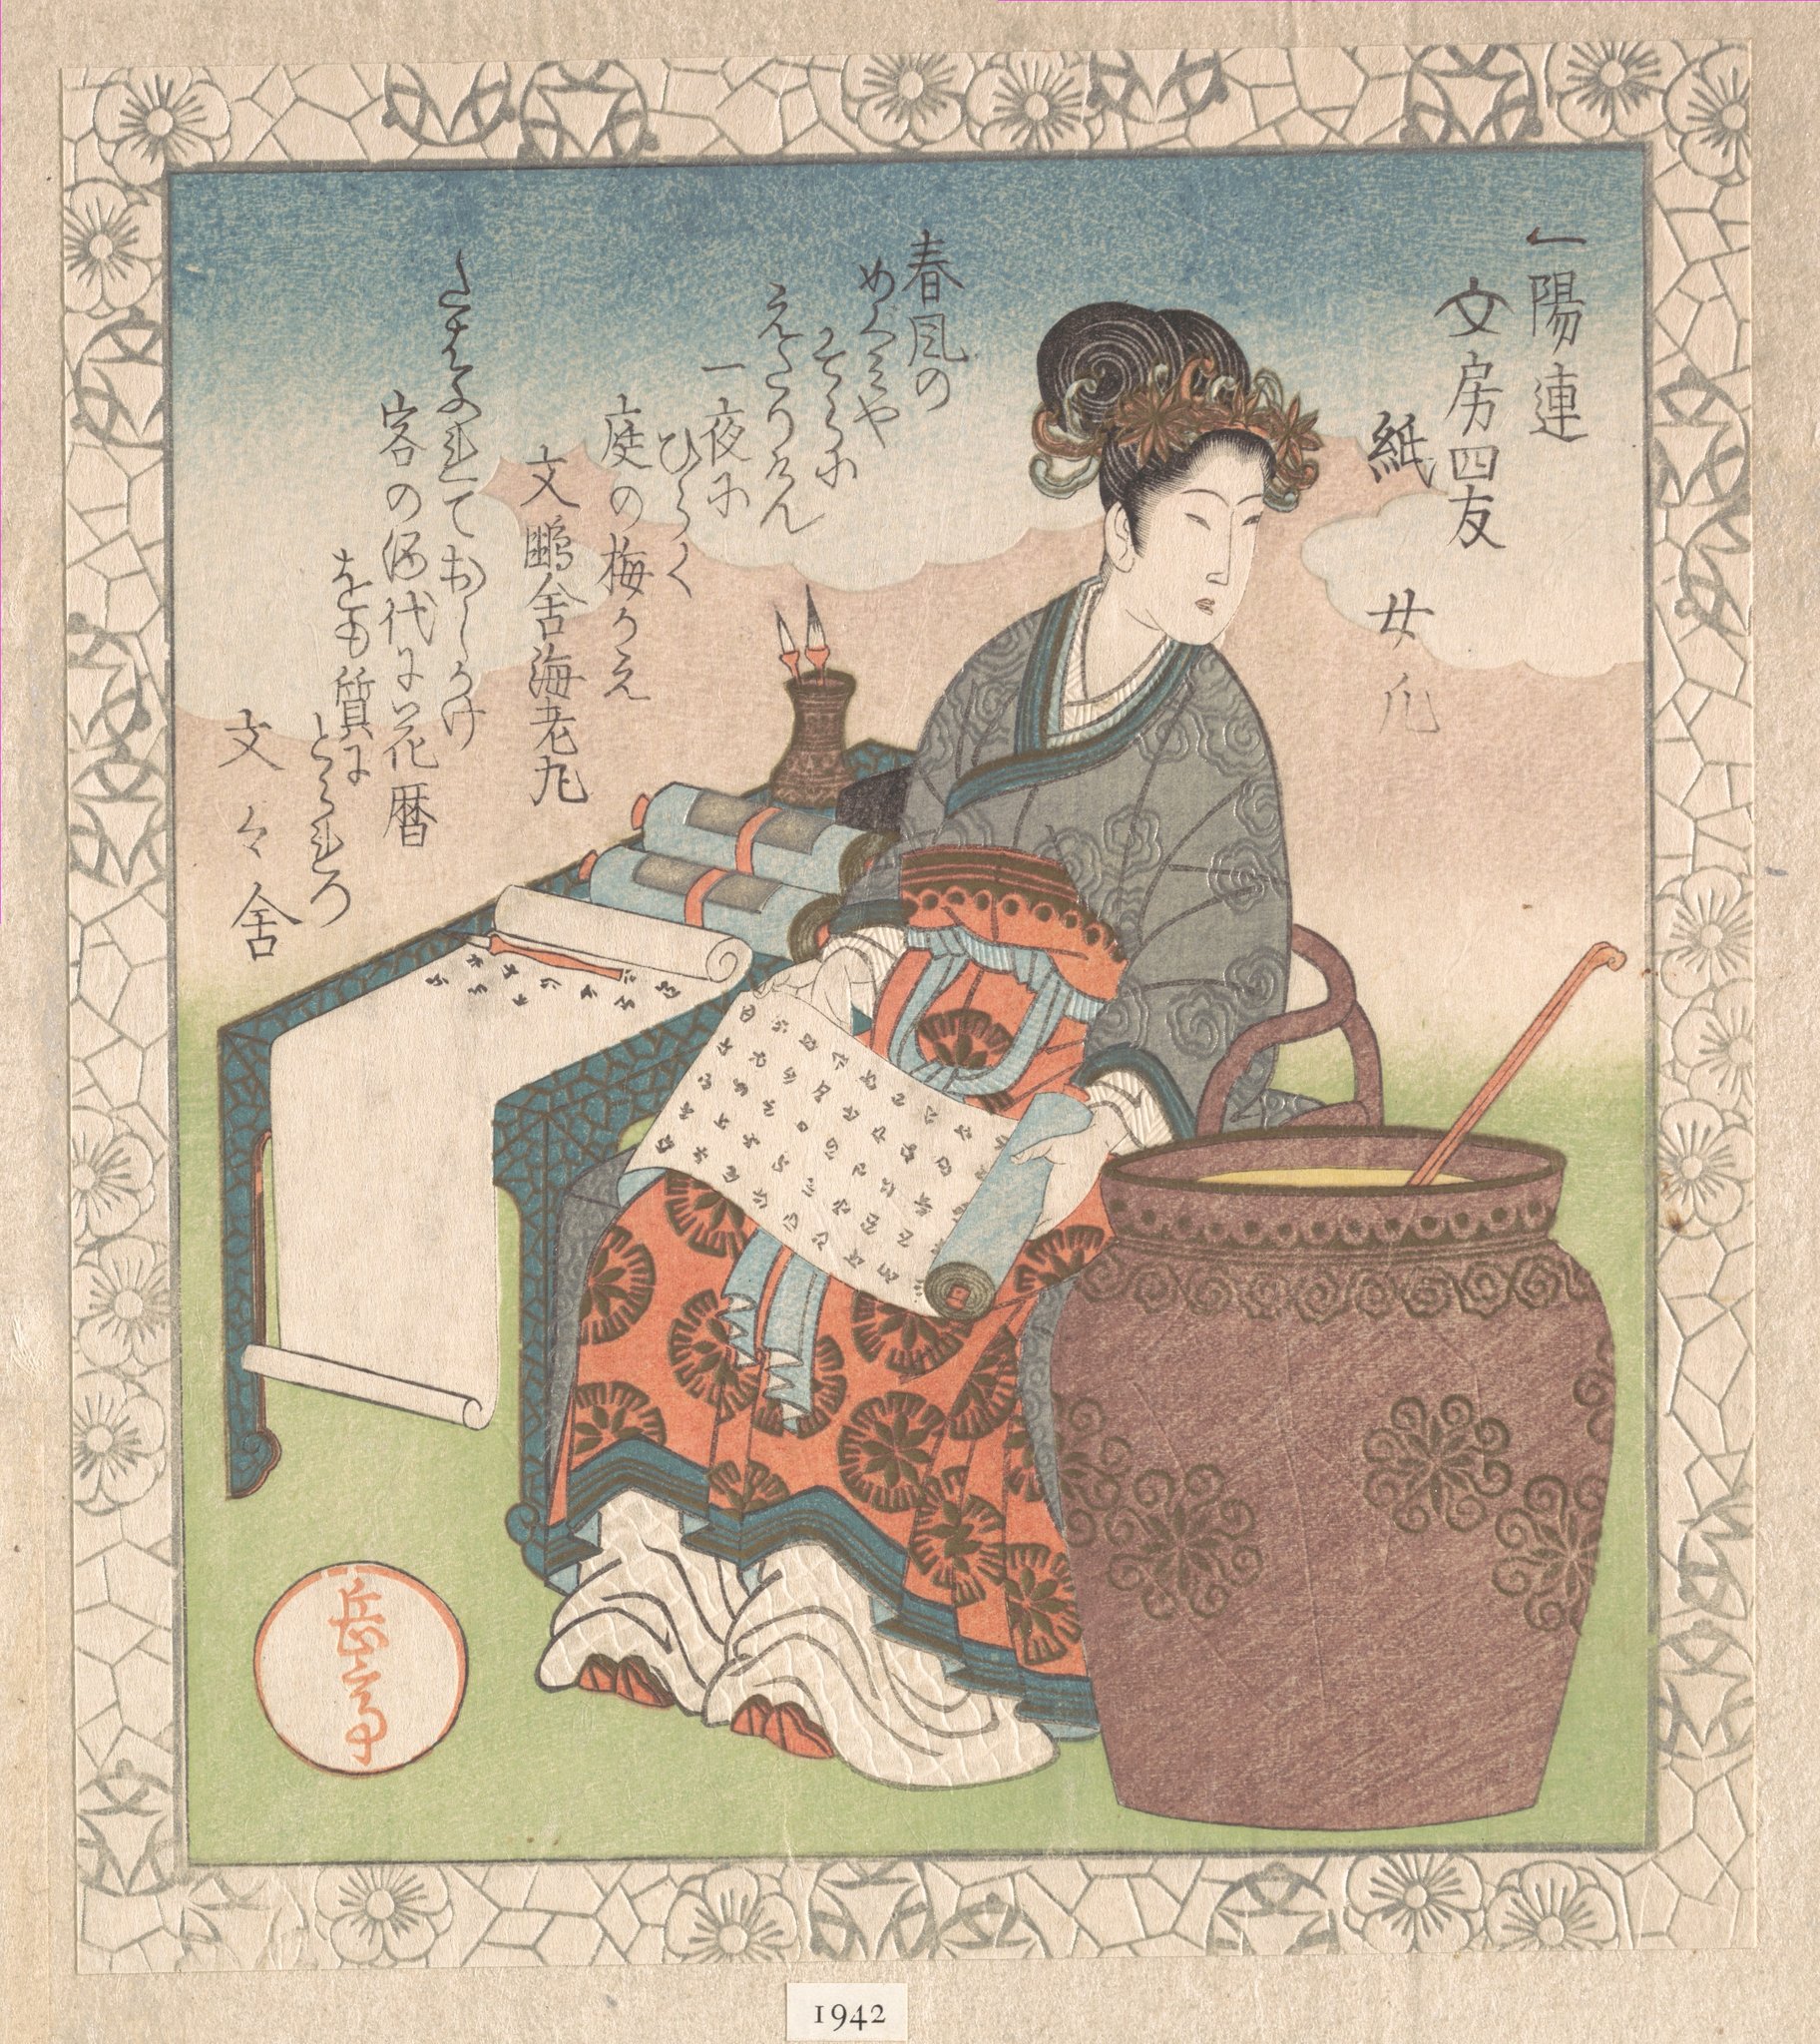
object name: print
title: Nuji (Japanese: Joki; female attendant who compiled writings by Daoist sages); “Paper” (Kami), from Four Friends of the Writing Table for the Ichiyō Poetry Circle (Ichiyō-ren Bunbō shiyū) From the Spring Rain Collection (Harusame shū), vol. 1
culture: japanese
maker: yashima gakutei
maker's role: artist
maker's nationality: japanese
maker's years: 1786-1868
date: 1827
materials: ink, paper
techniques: surimono, woodblock print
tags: scrolls,women,brushes